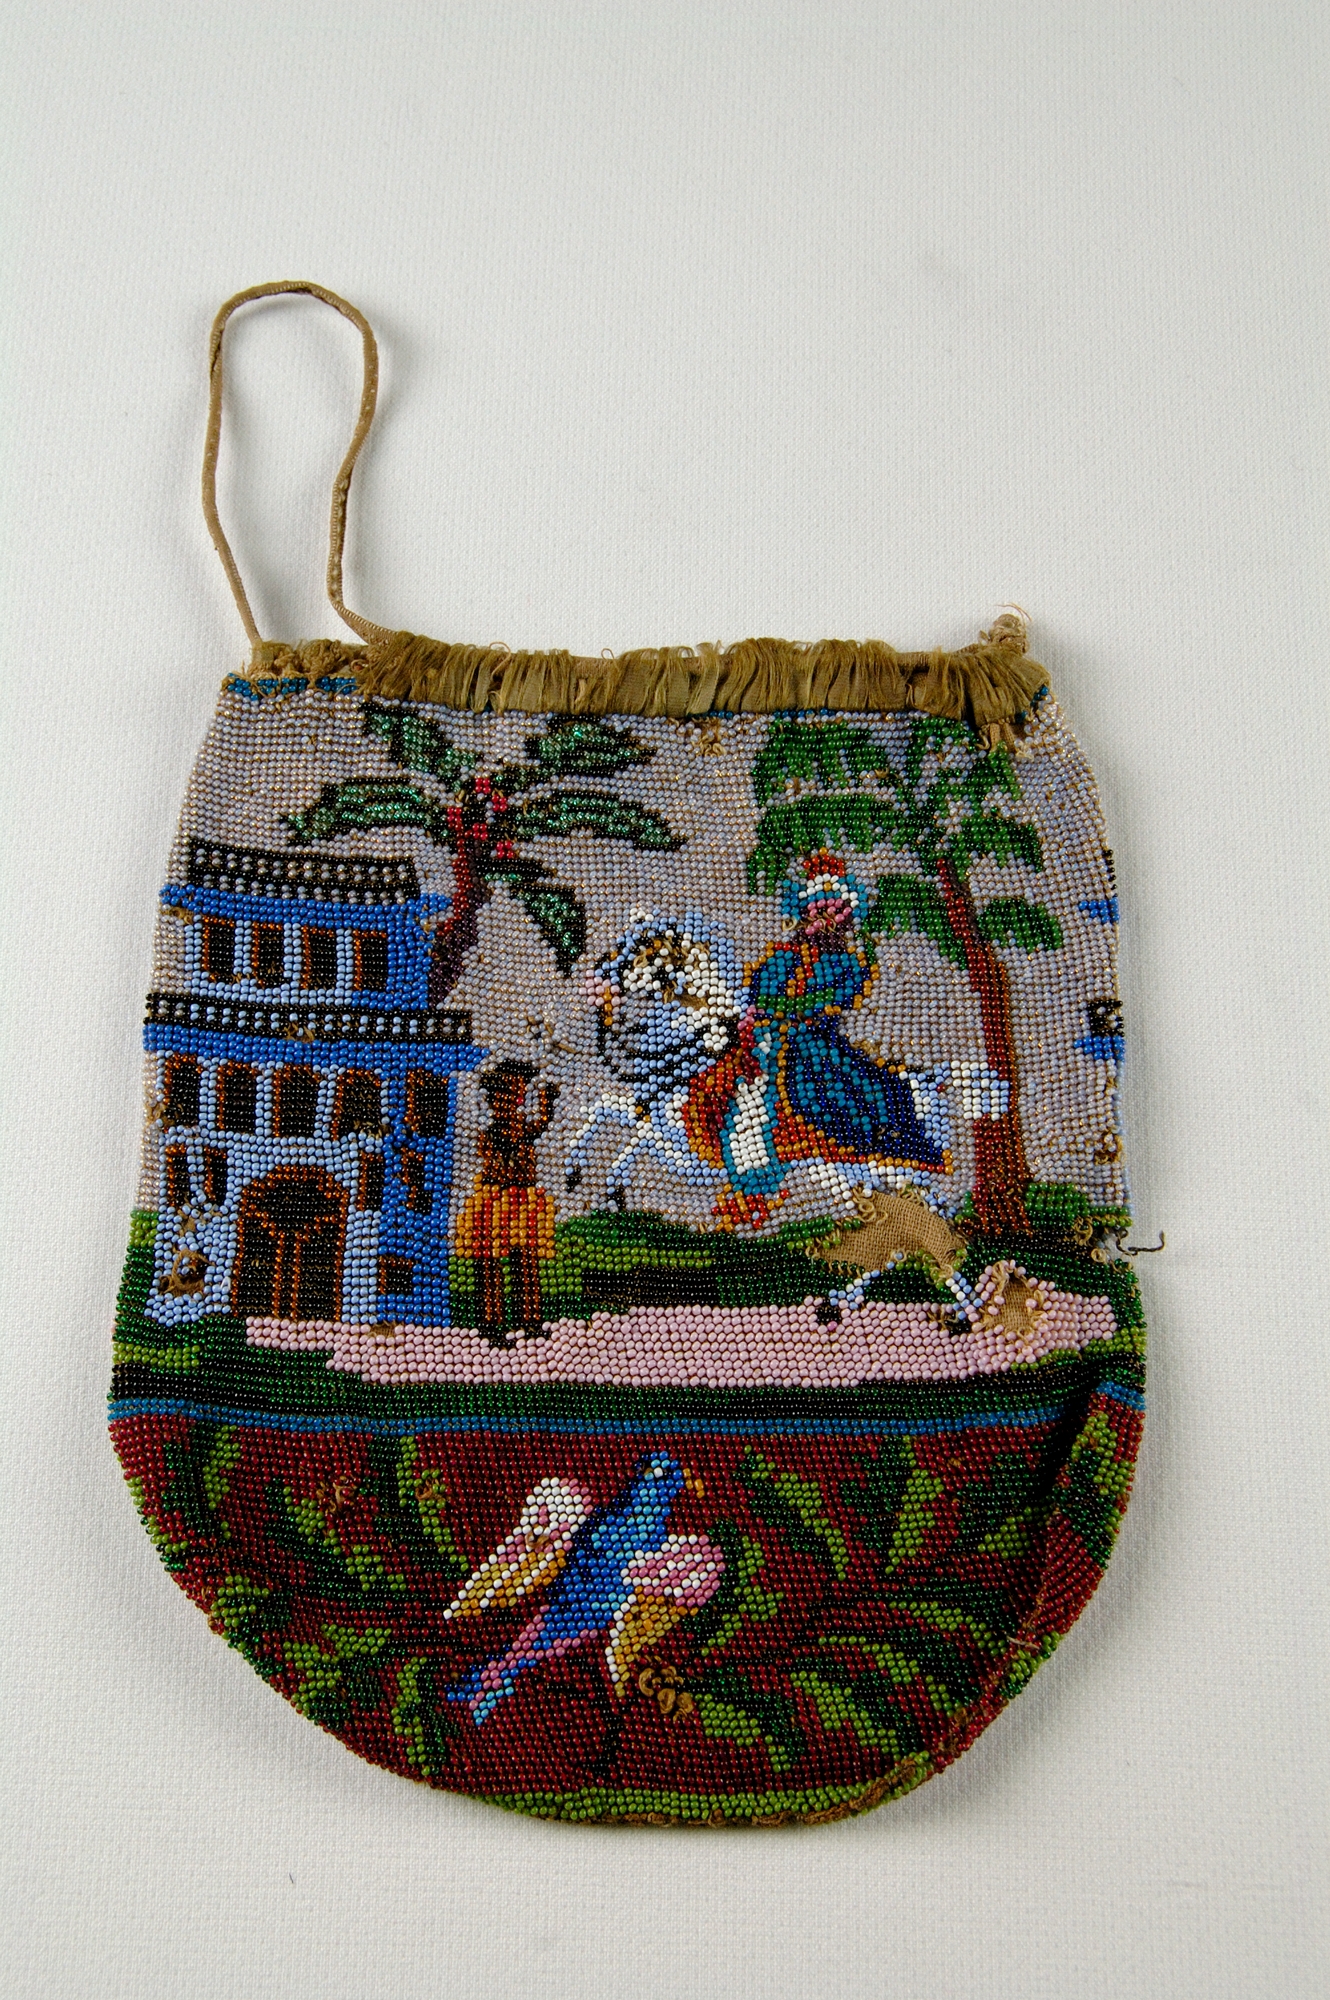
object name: pouch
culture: american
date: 1830-1860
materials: glass, linen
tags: birds,horses